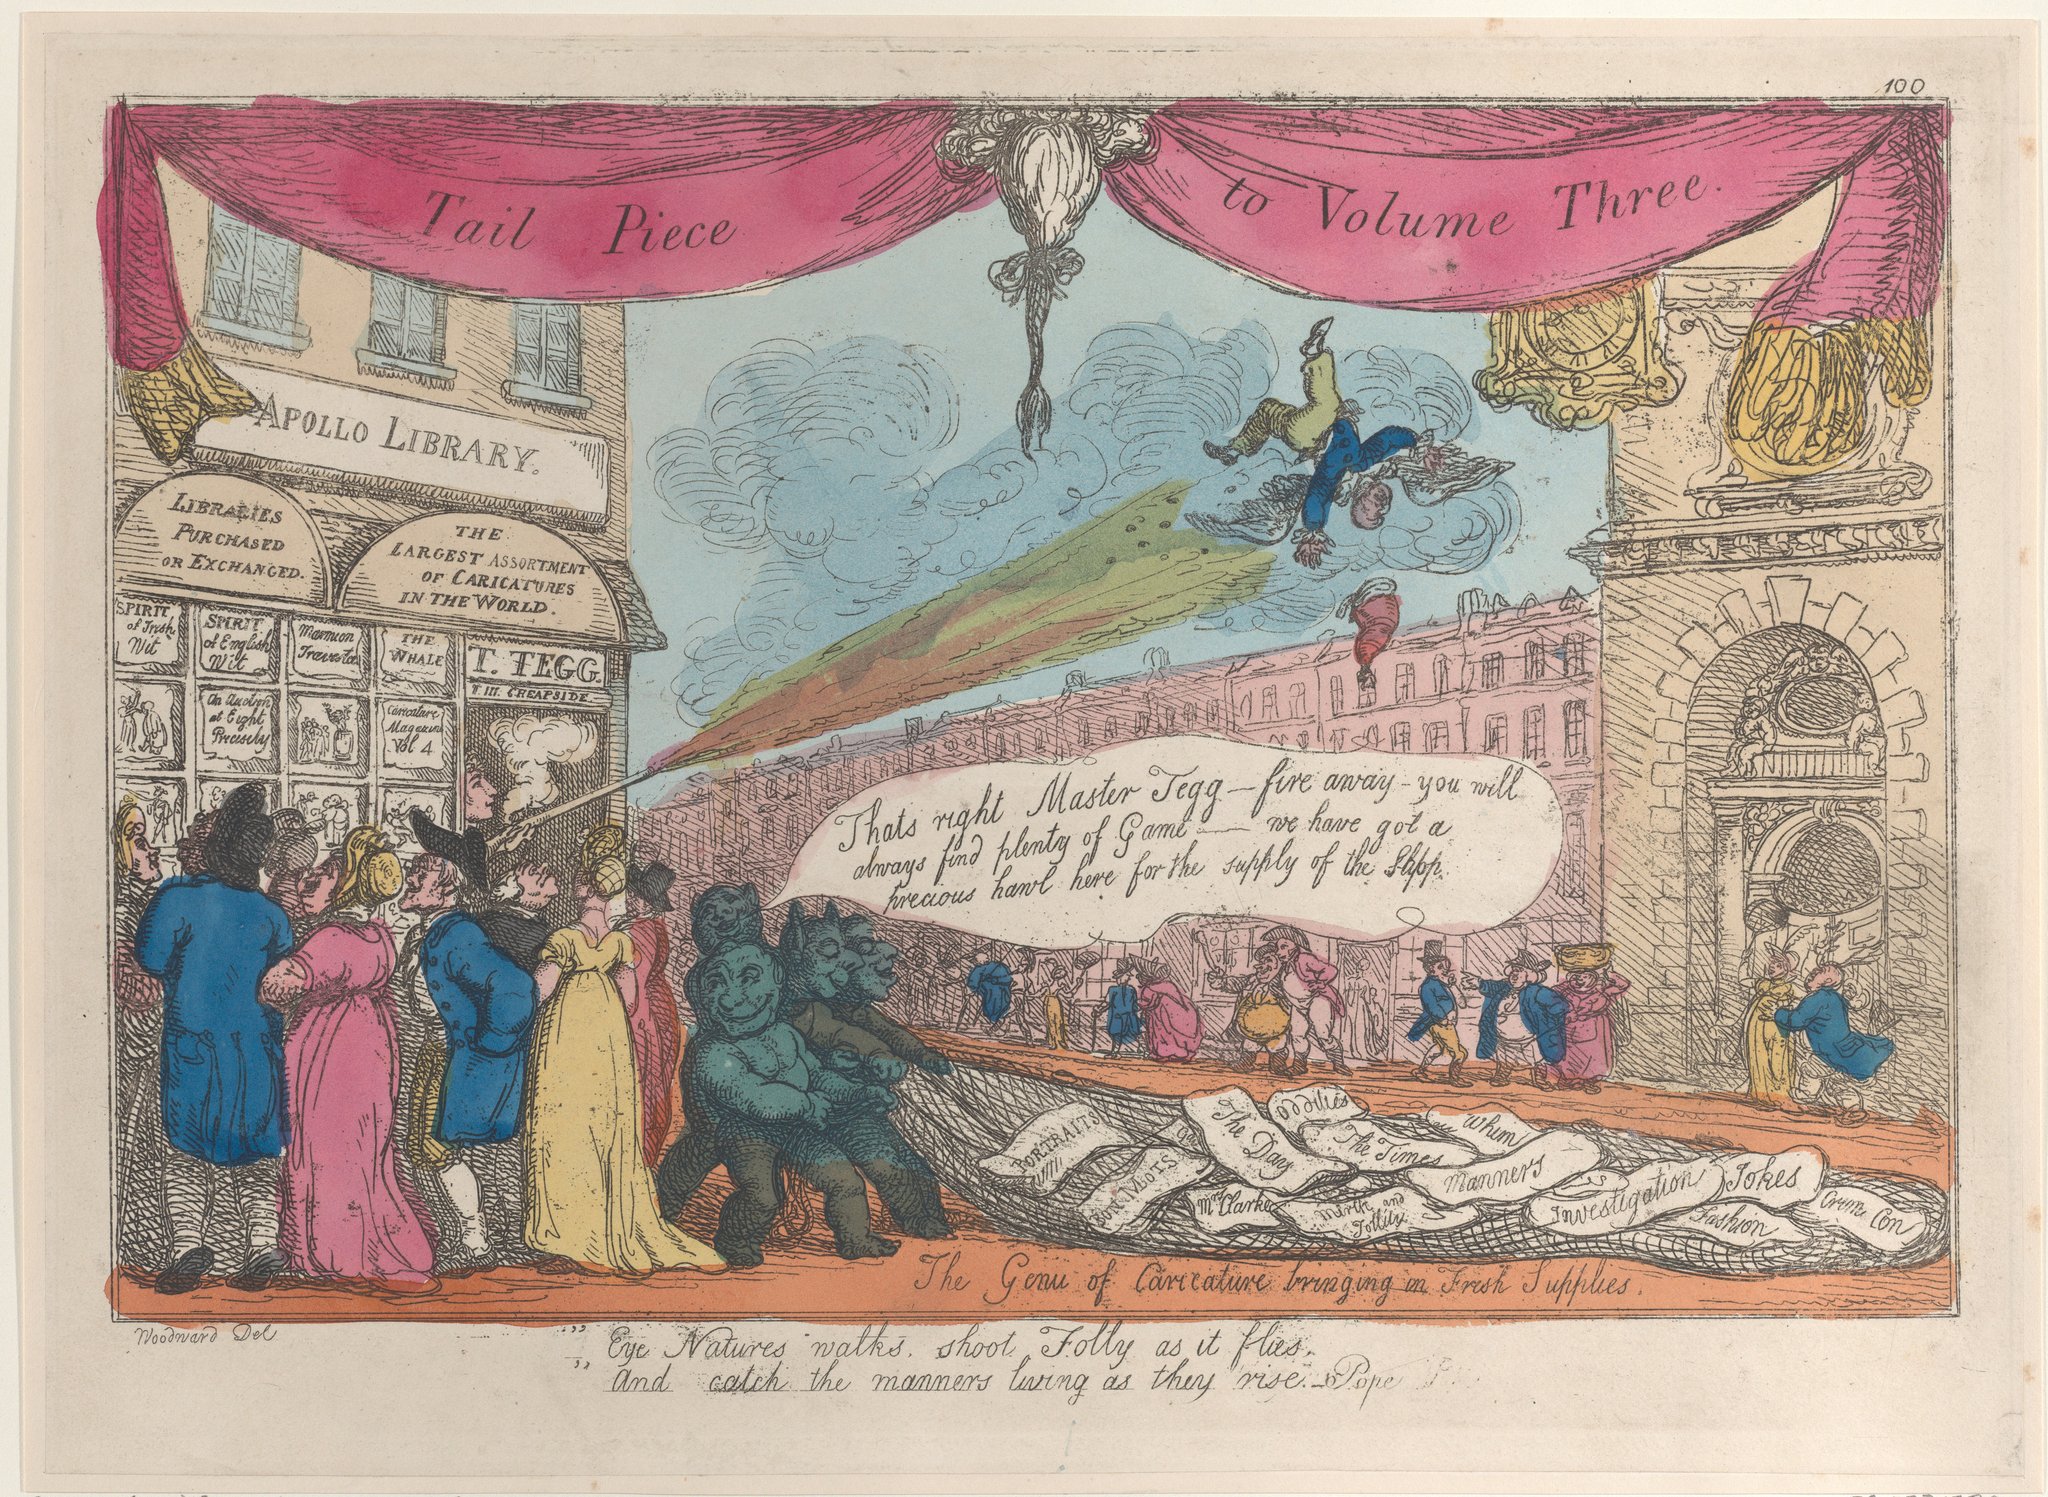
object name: print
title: Tail Piece to Volume Three: The Genii of Caricature Bringing in Fresh Supplies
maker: thomas rowlandson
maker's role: artist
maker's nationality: british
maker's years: 1757-1827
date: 1809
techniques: etching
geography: london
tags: satire,men,women,demons